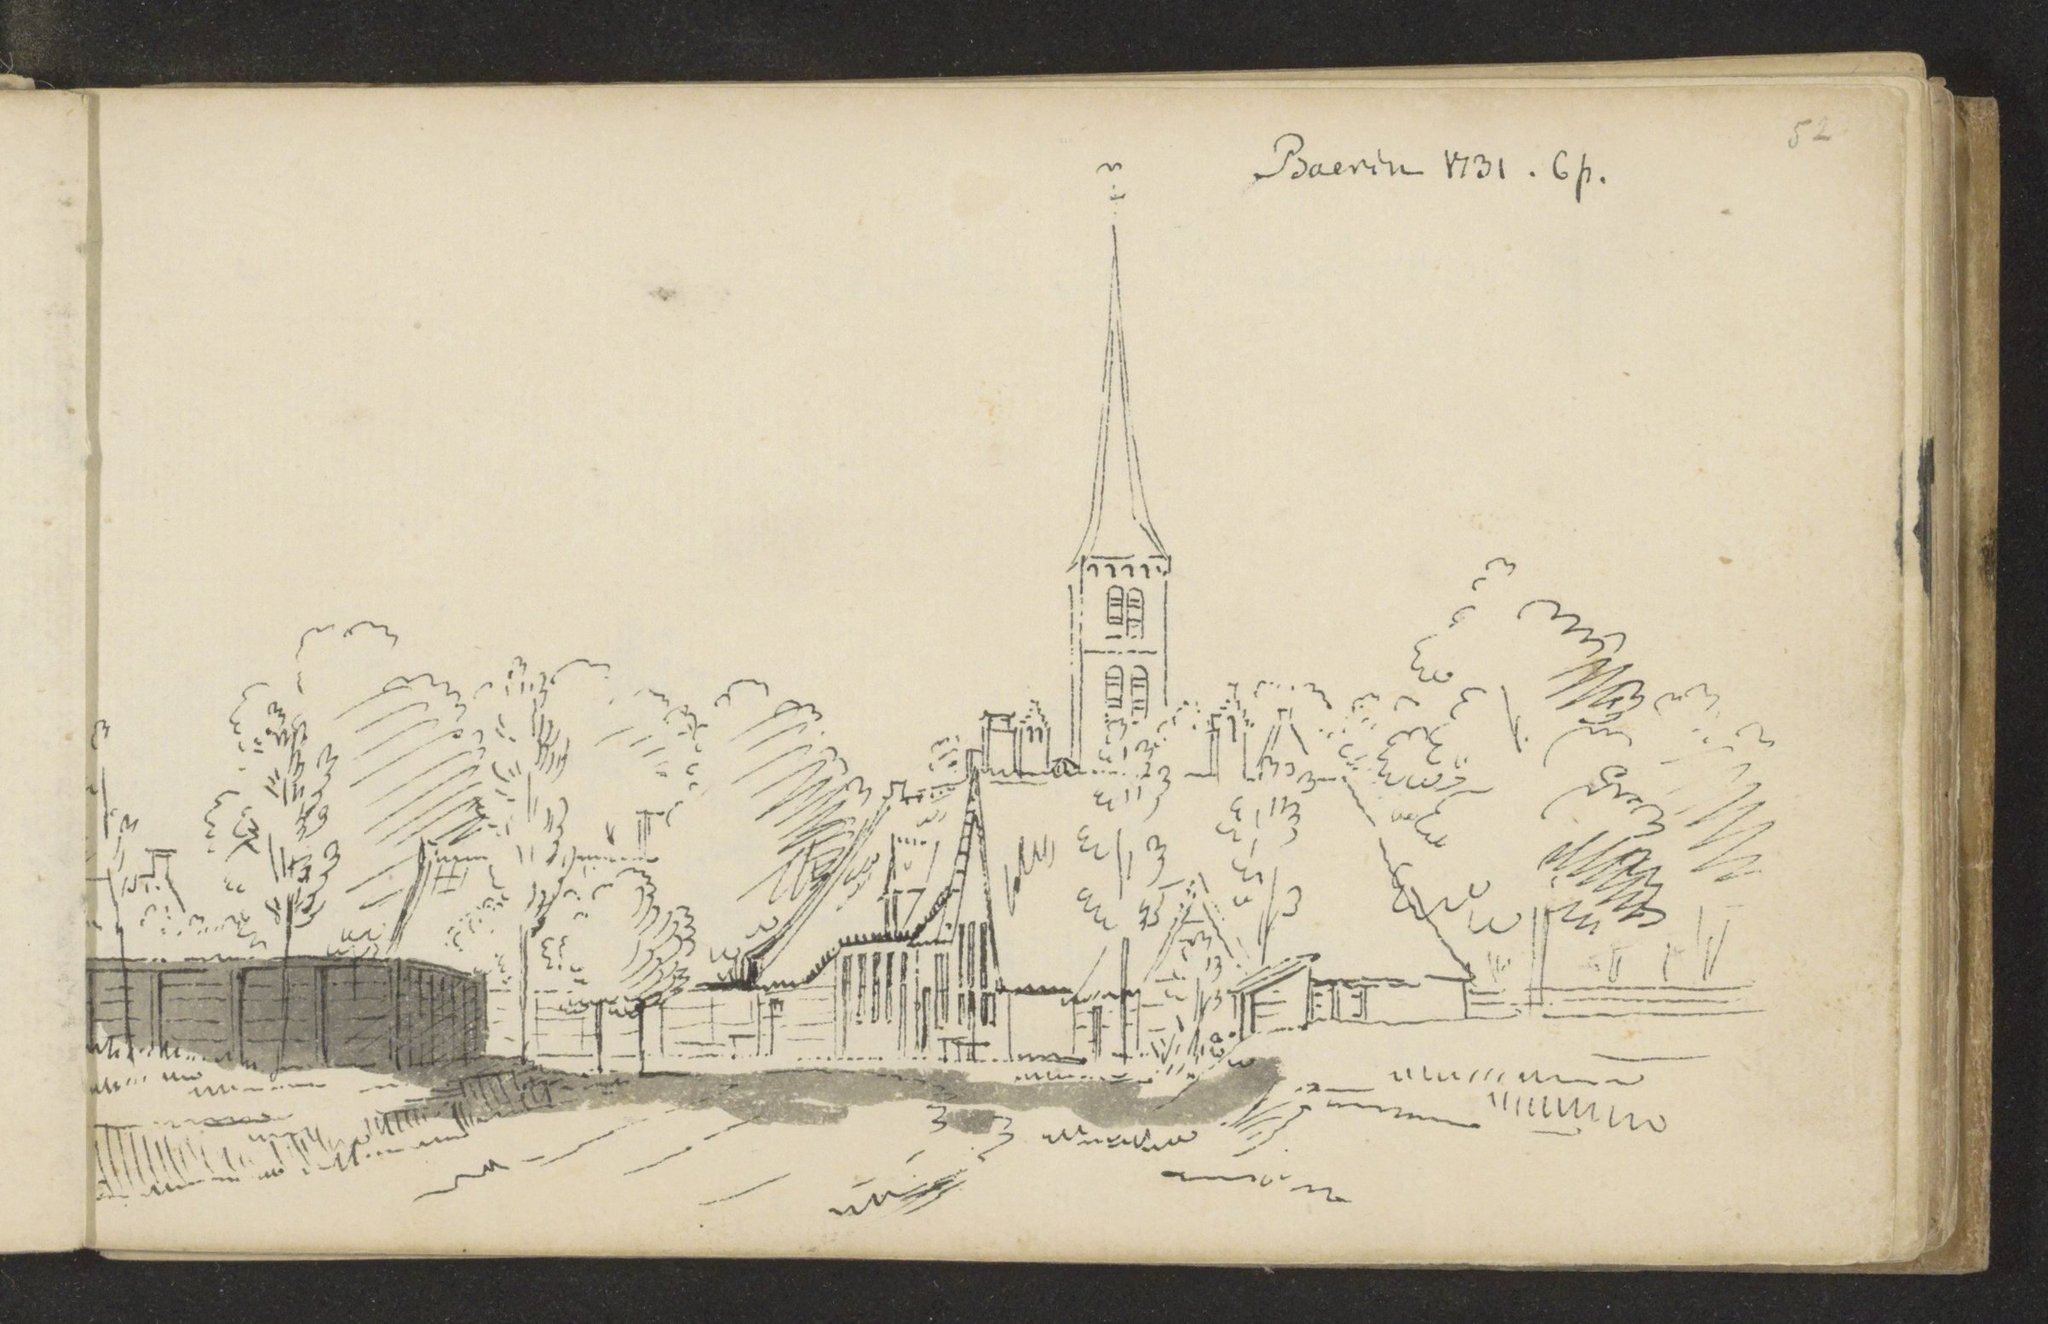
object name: sketchbook leaf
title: Dorpsgezicht te Baarn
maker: abraham de haen (ii)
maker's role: draughtsman, print maker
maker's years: 1707-1748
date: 1731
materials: ink, paper, pencil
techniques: brush, pen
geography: baarn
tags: village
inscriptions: date and inscription: ‘Baeren 1731.cp.’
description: Blad 52 recto uit een schetsboek met 78 bladen.